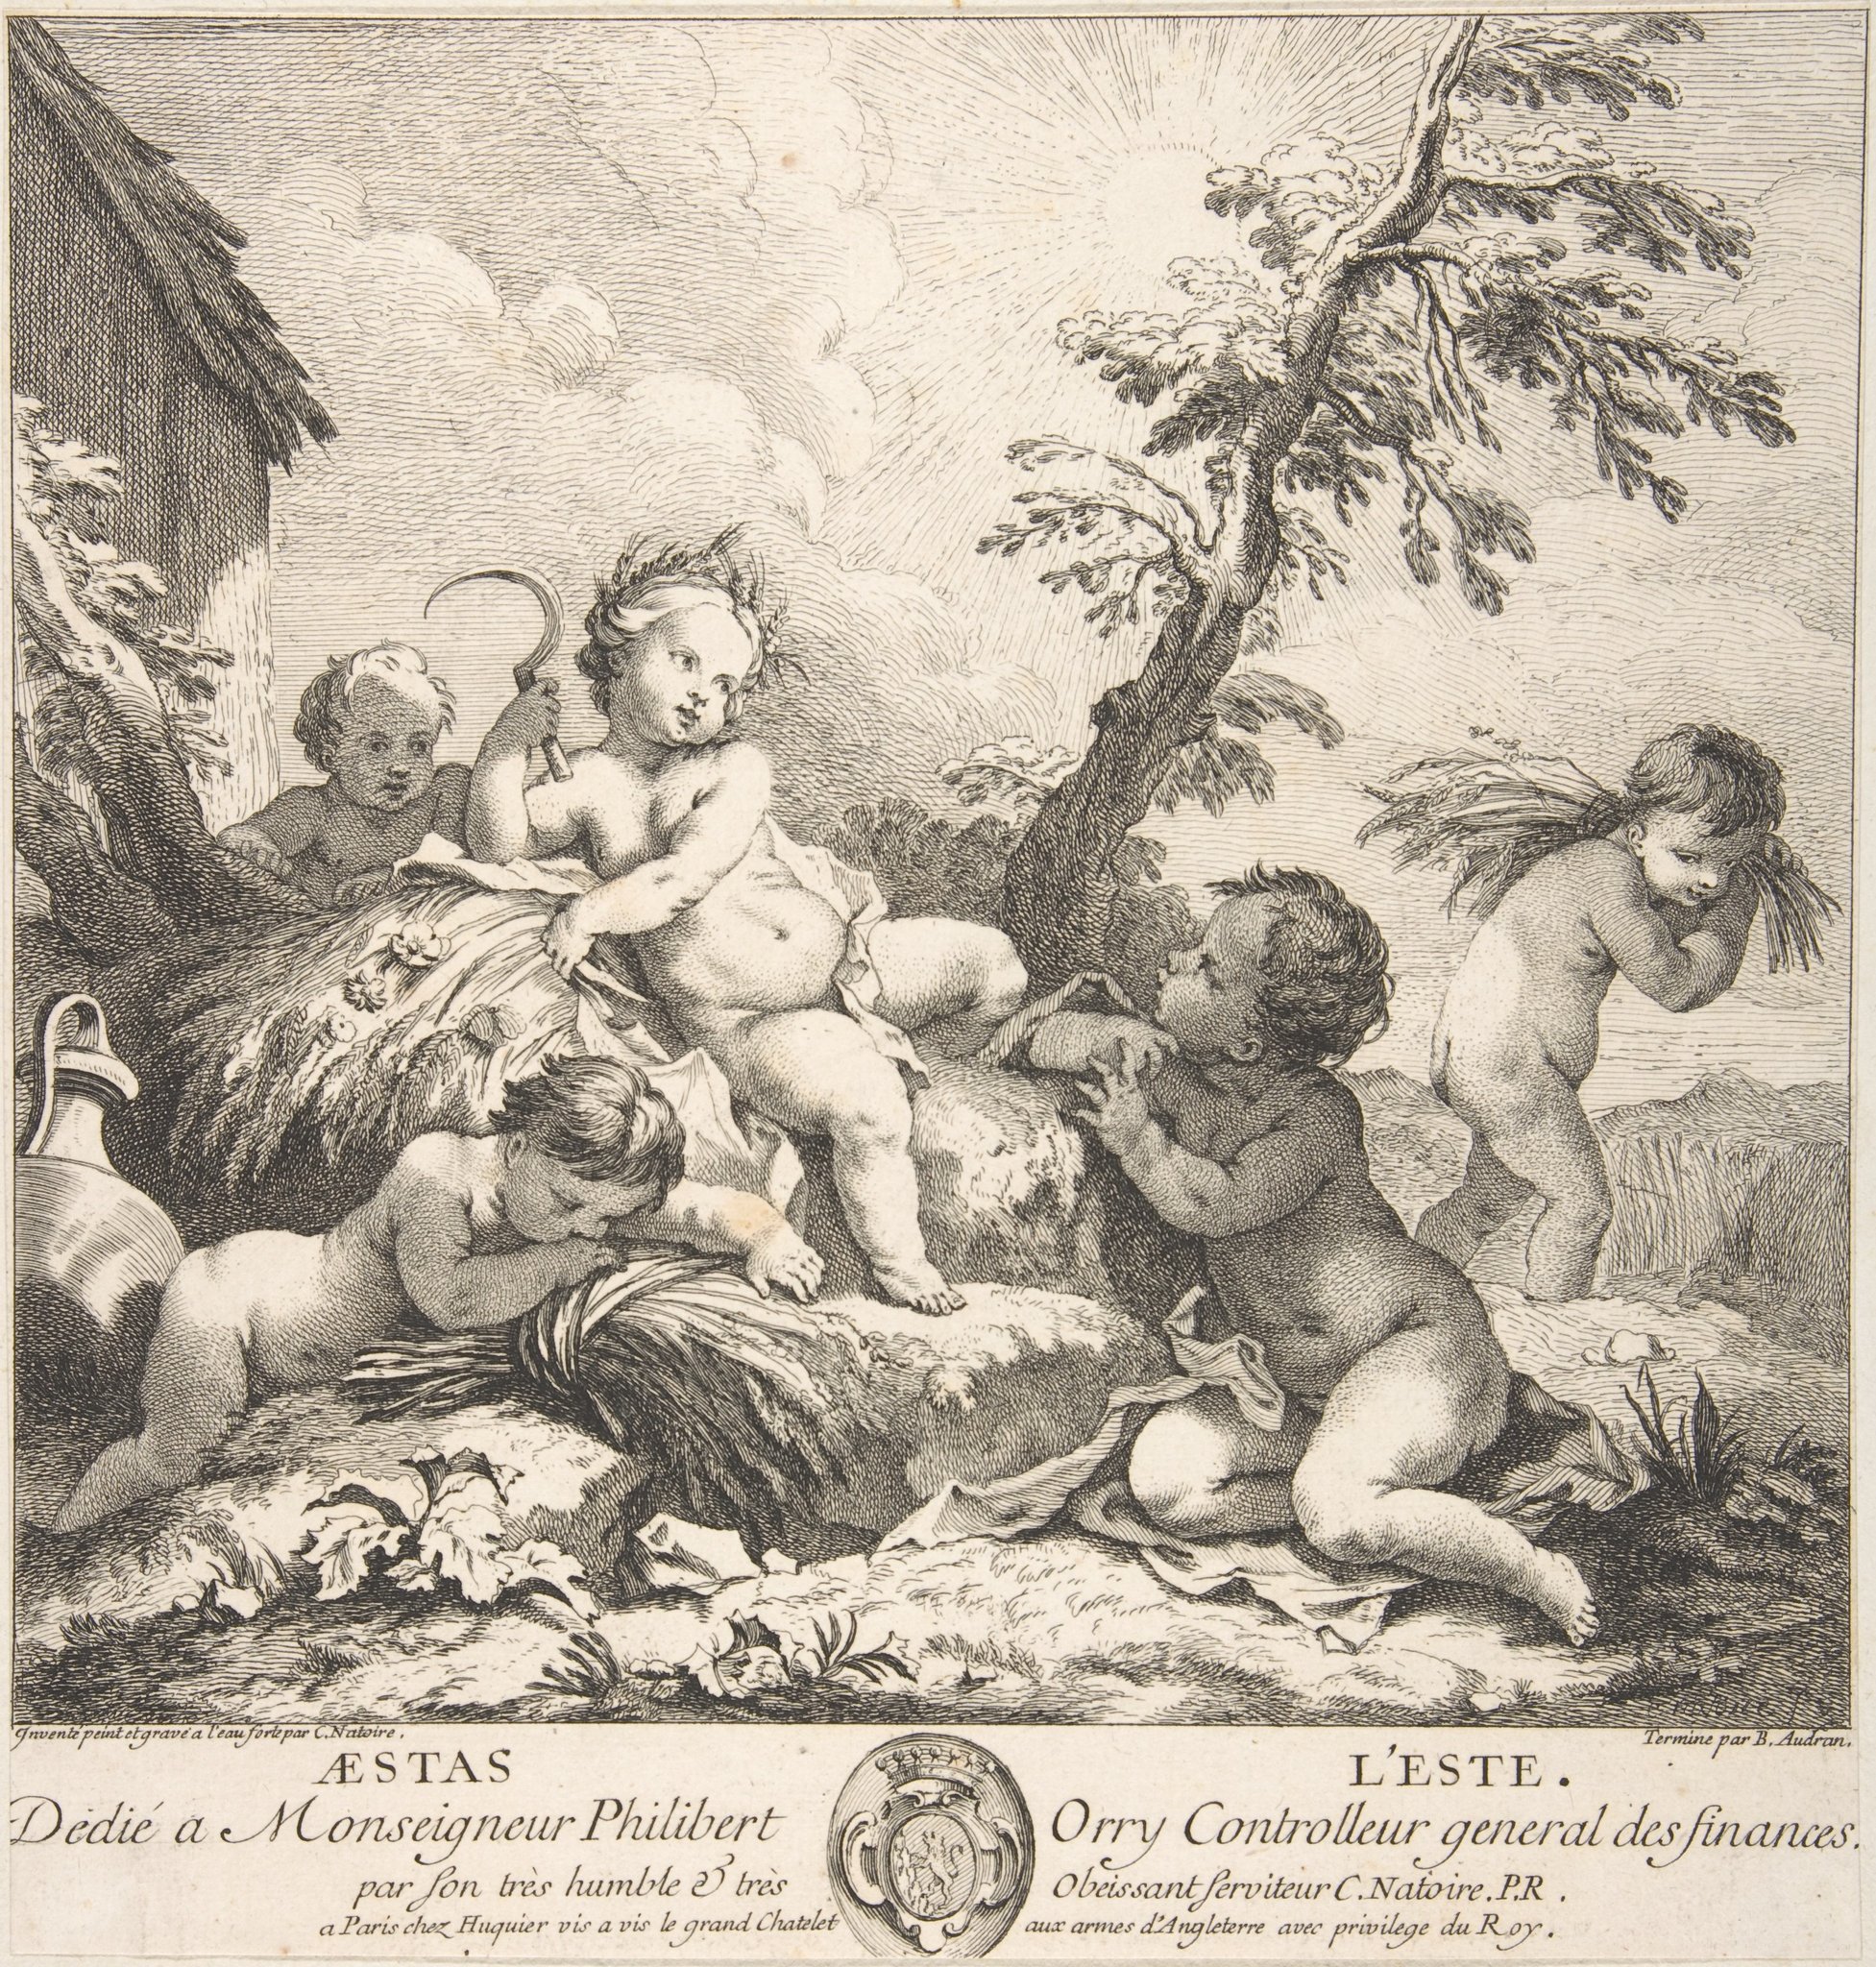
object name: print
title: Summer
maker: charles joseph natoire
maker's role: artist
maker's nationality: french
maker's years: 1700-1777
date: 1735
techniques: engraving, etching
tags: children,summer